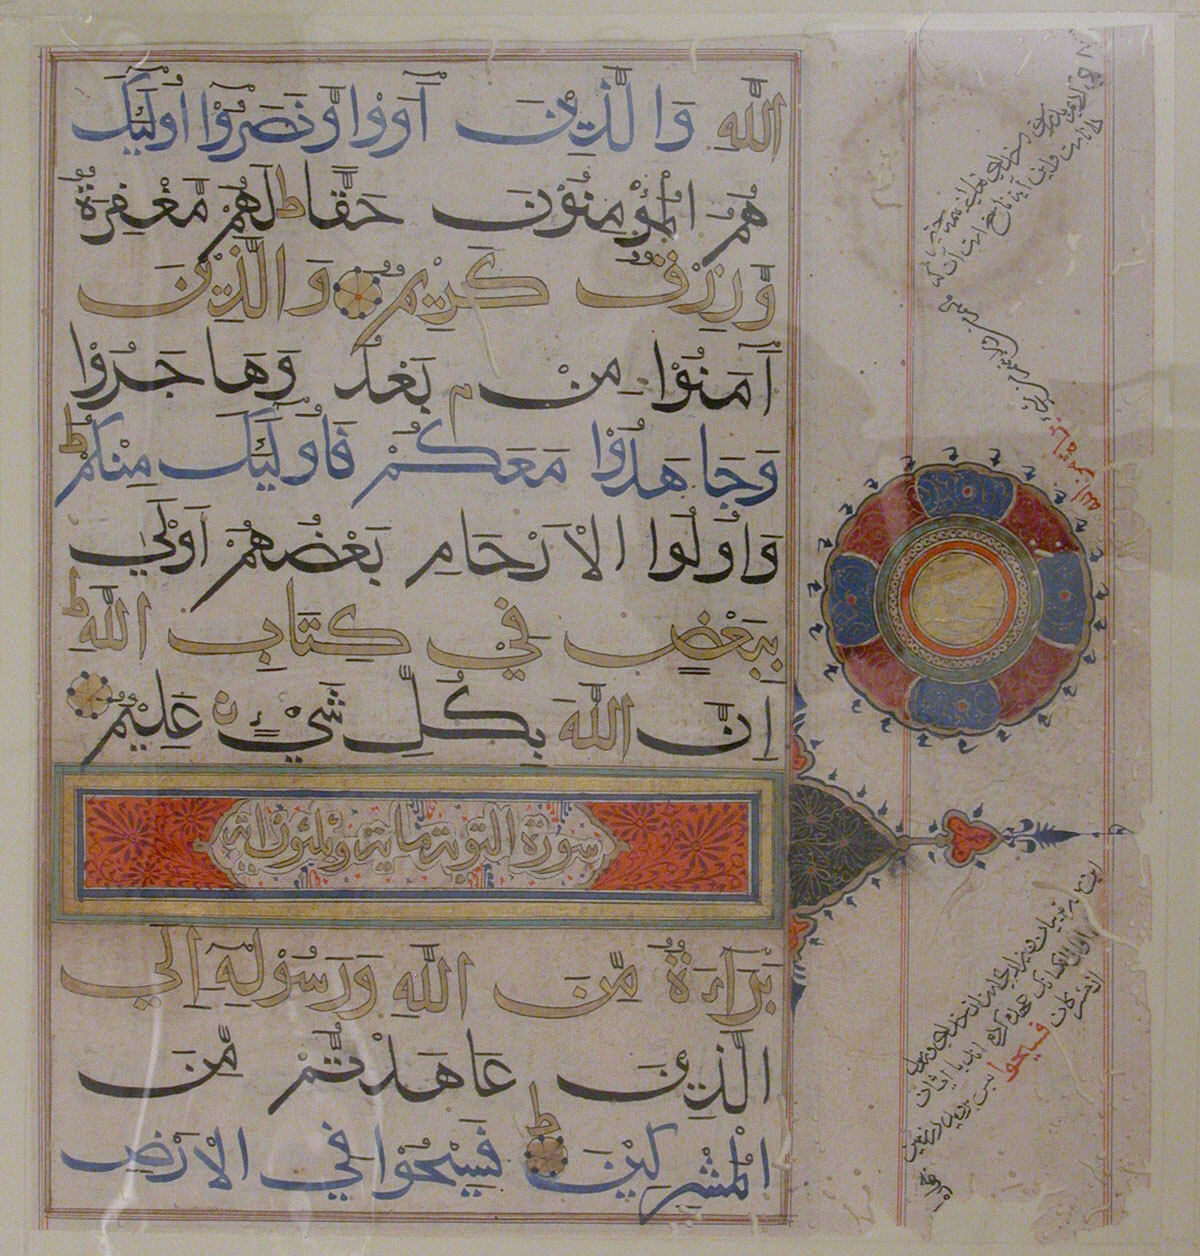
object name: folio from a non illustrated manuscript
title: Folio from a Qur'an Manuscript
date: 1401-1433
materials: gold, ink, paper, watercolor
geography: india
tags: qur'an